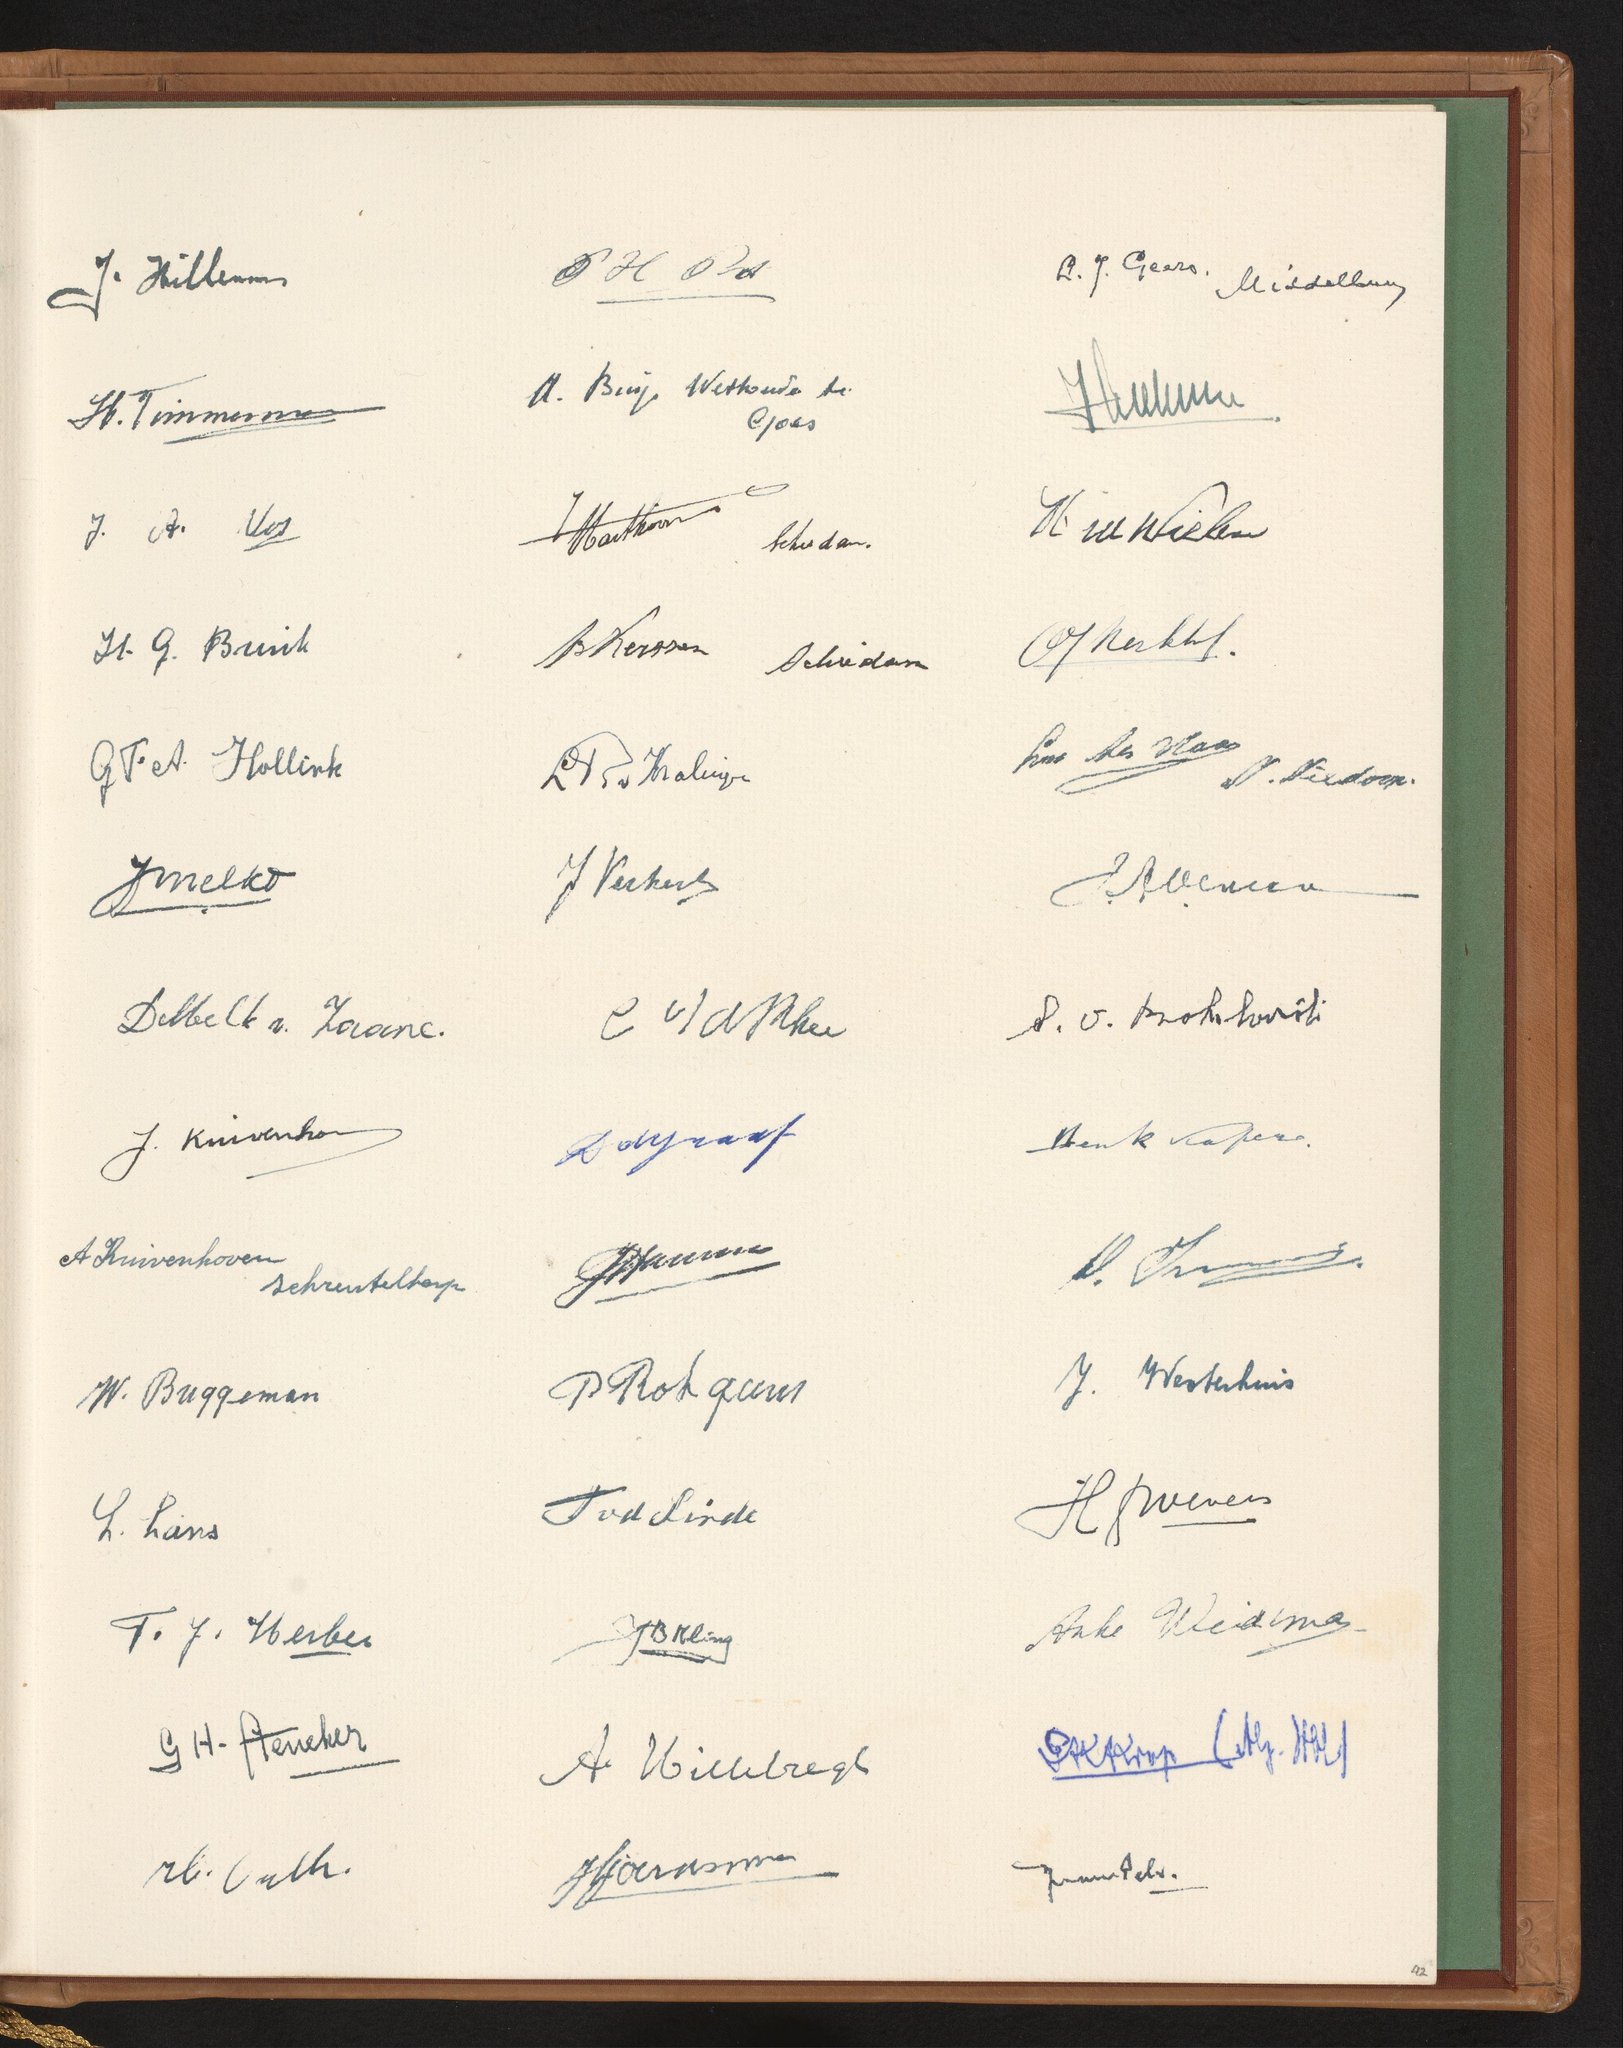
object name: text sheet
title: Blad met handtekeningen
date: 1949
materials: ink, paper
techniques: handwriting, pen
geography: netherlands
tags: modern professional organization, trade union, reception, cocktail party, handwriting, written text, amsterdam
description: Blad met handtekeningen van aanwezigen op het afscheidsfeest. Onderdeel van het fotoalbum ter gelegenheid van het afscheid van Evert Kupers als voorzitter van de NVV op 14 juli 1949 in Amsterdam.